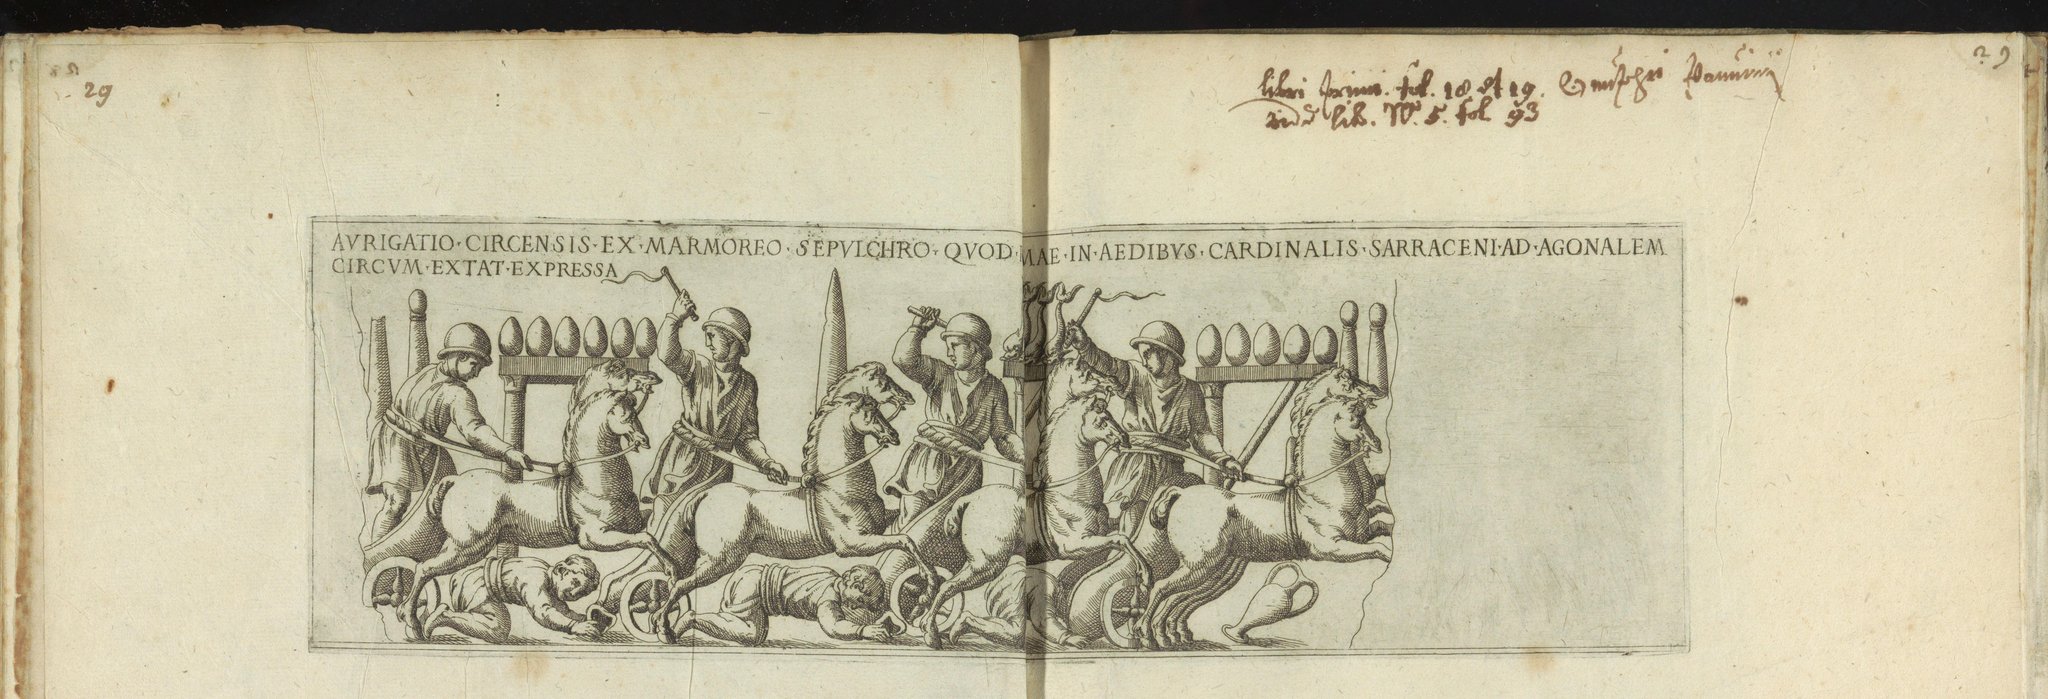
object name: print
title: Vier wagenmenners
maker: onofrio panvinio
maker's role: priest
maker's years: 1530-1568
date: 1580-1600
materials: paper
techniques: etching, intaglio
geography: italy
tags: wagon racing with two-wheeled vehicle, e.g.: chariot, sulky, charioteer, 'auriga', whip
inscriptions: number: ‘29’, inscription: ‘libri [...] fol. 18 - 19 [...] lib. vol. 5. fol. 93/ [...] fol. 32 - 33 [...]’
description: Deze prent is gebruikt voor de publicatie: Panvinio, Onofrio. De Ludis Circensibus. Venetië: Giovanni Battista Ciotti, 1600.